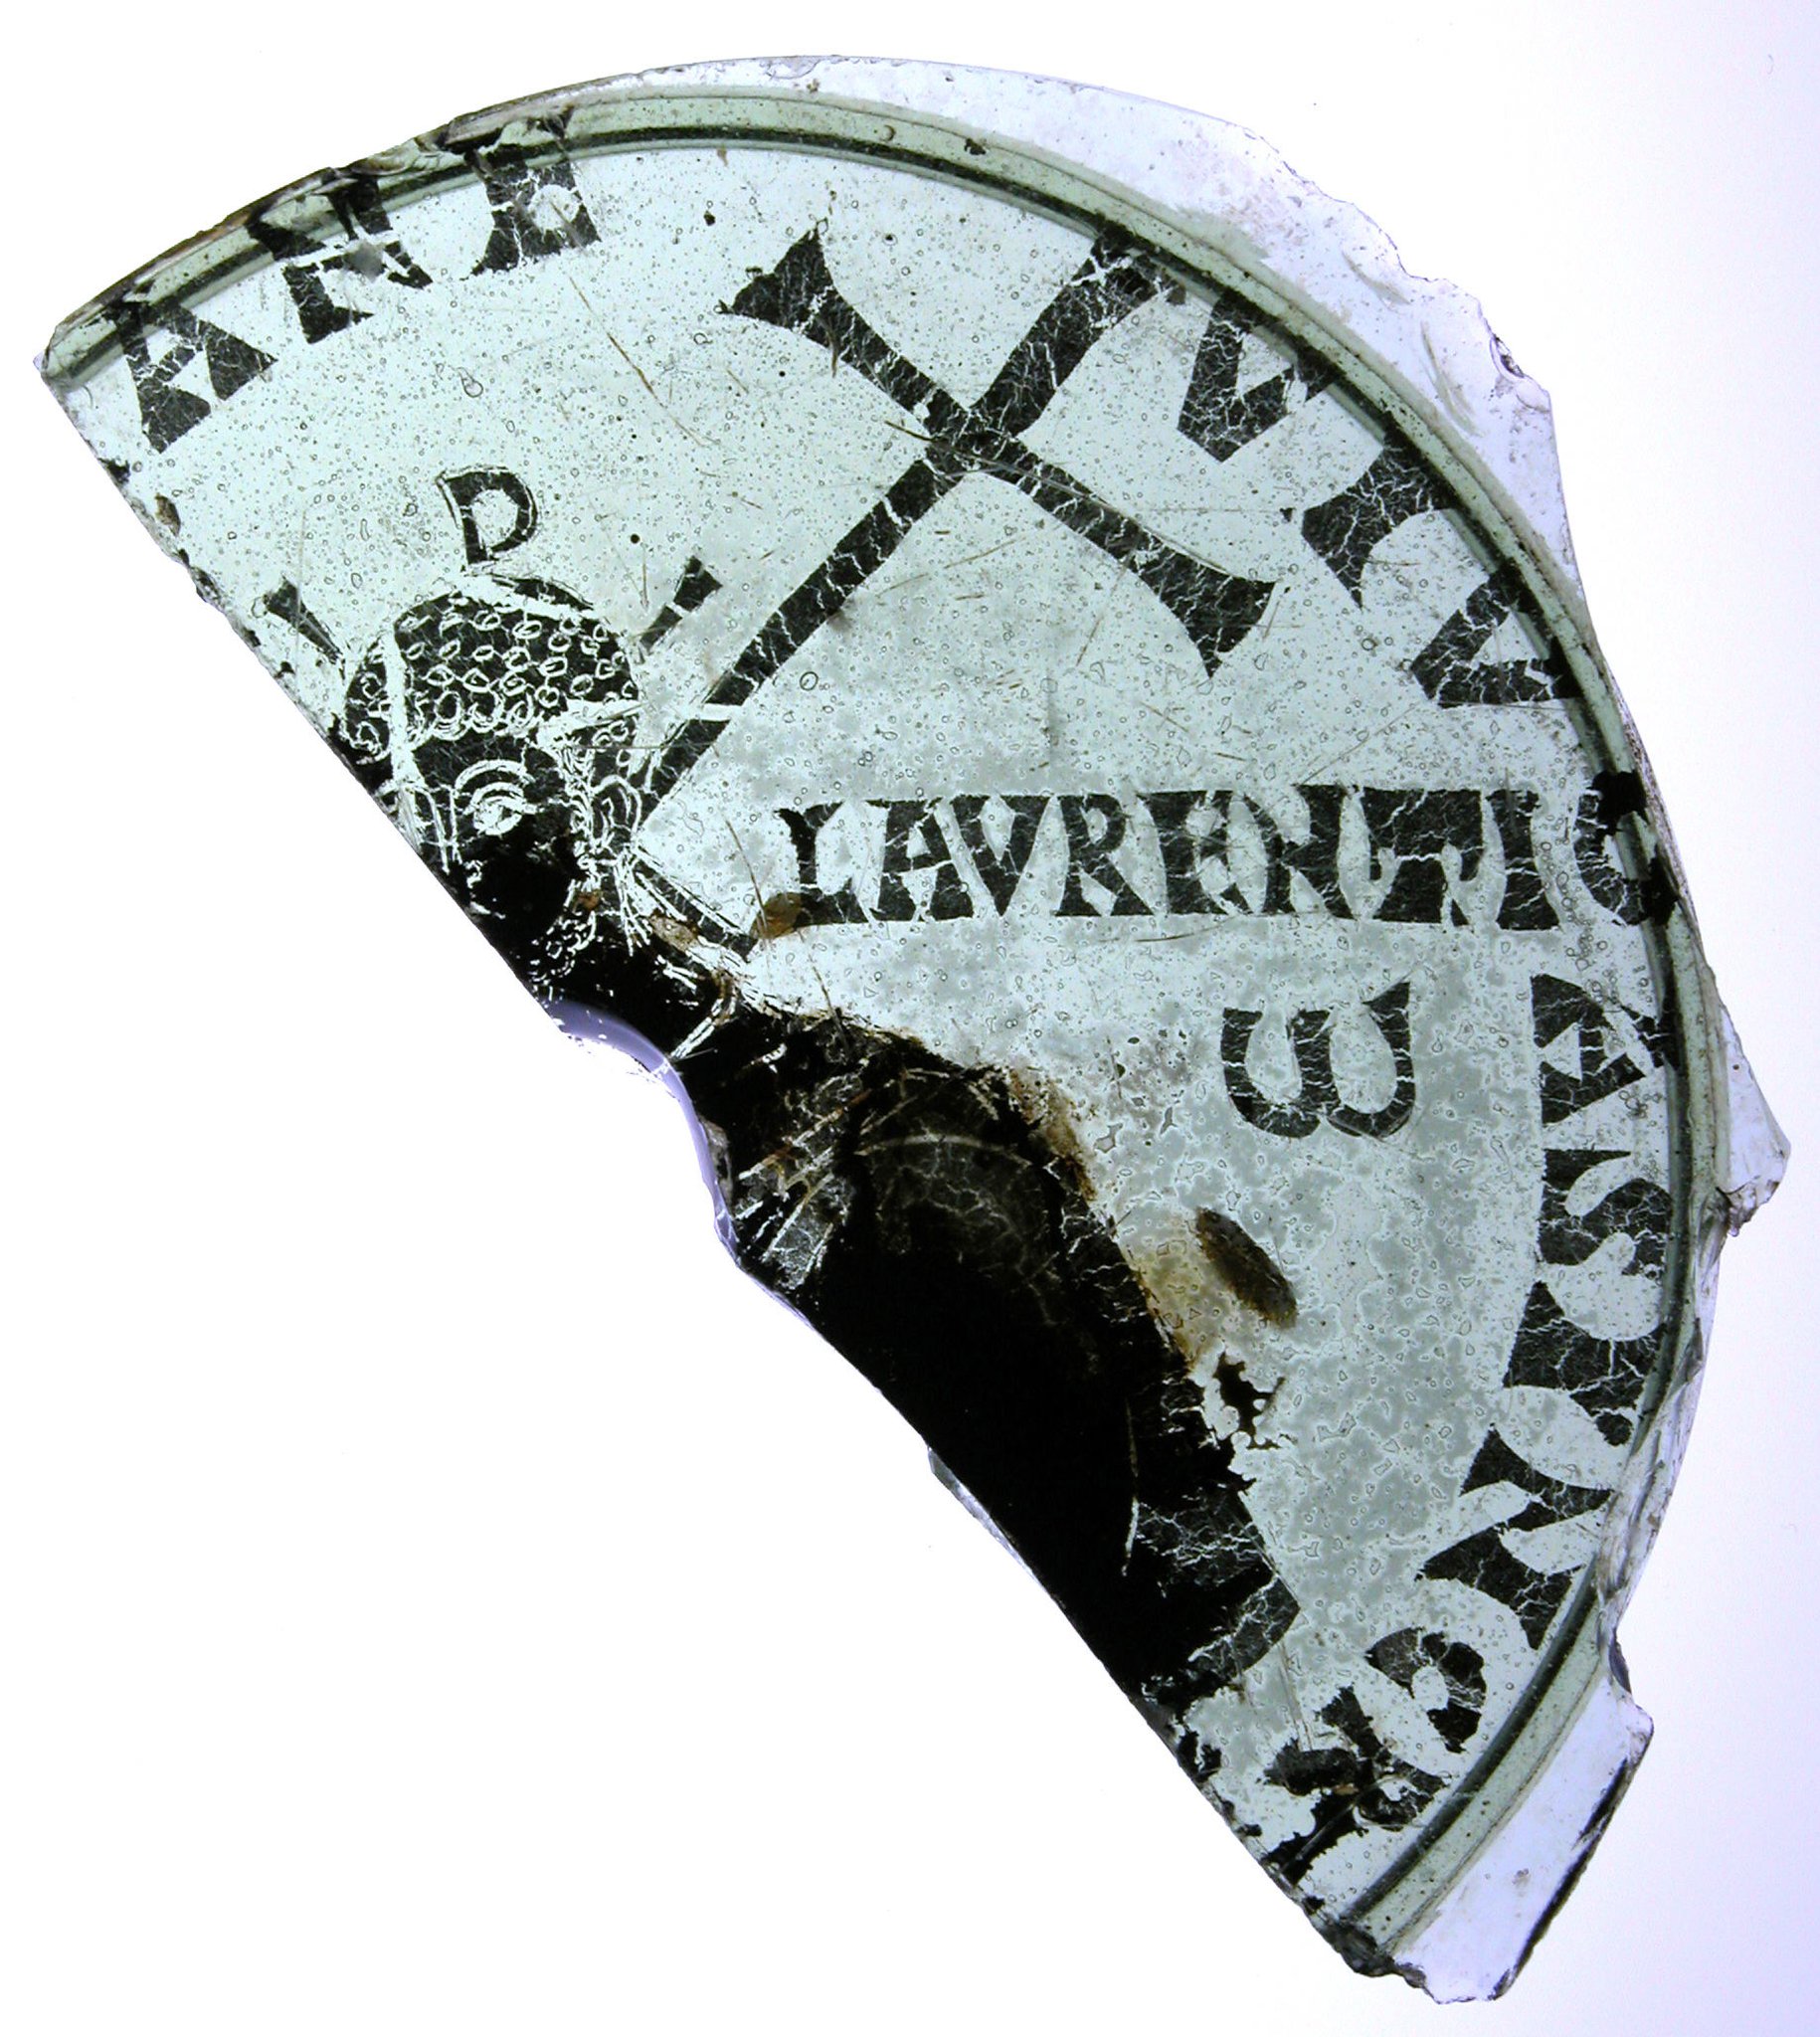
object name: fragment of a bowl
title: Fragmentary Bowl Base with Saint Lawrence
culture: byzantine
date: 401-500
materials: glass, gold leaf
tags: bowls